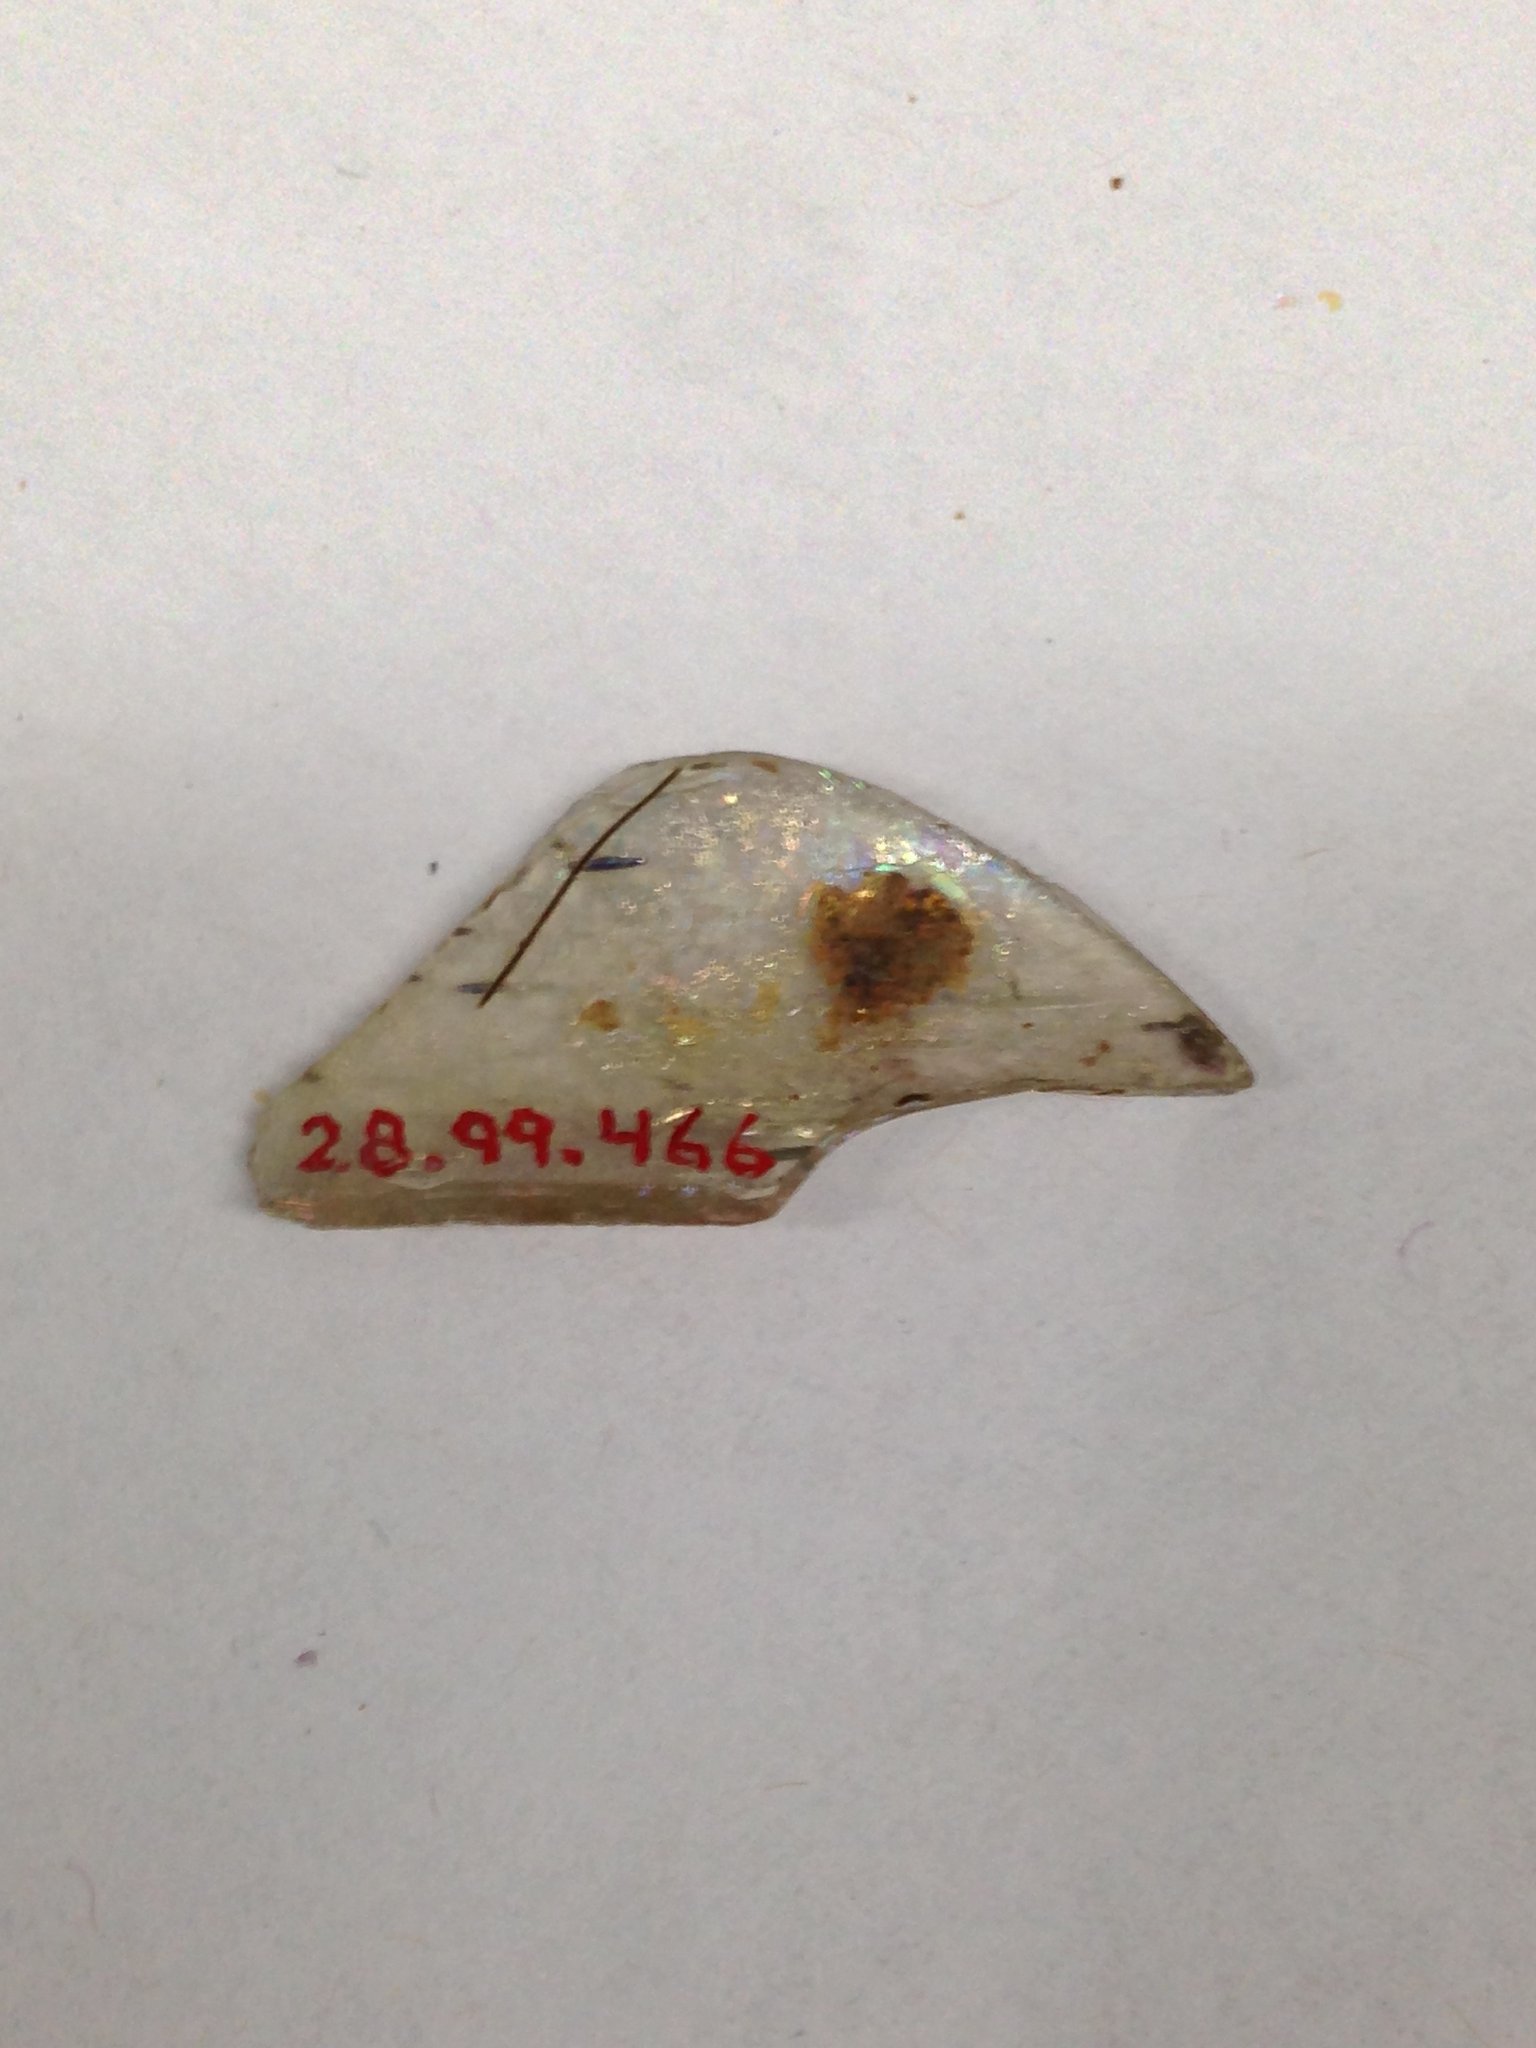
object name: fragment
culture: european or middle eastern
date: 1150-1250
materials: ceramic, glass